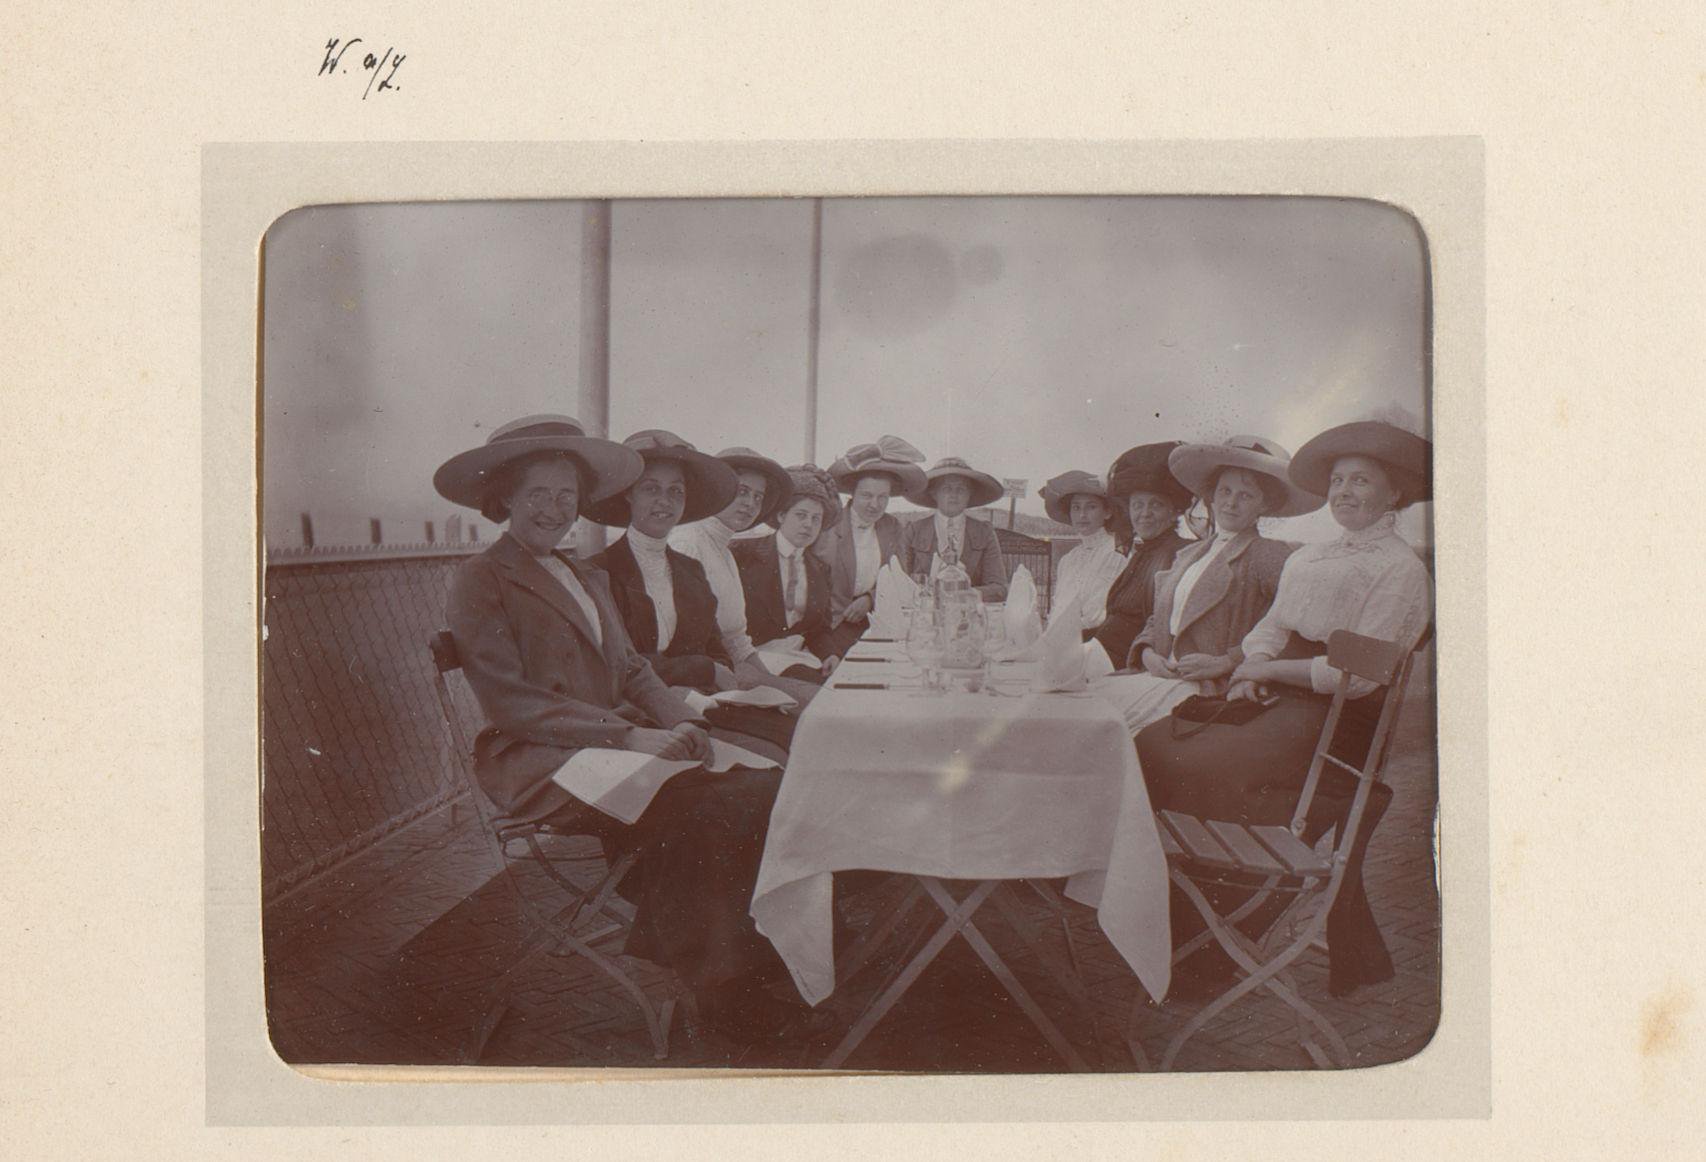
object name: album leaf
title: Groepsportret van vrouwen aan een gedekte tafel op een terras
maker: liesbeth overhoff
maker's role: fotograaf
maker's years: 1895-1969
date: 1912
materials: paper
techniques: gelatin silver print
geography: wijk aan zee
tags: historical persons - bb - woman, adult woman (+ six persons)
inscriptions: inscription: ‘W a/Z.’